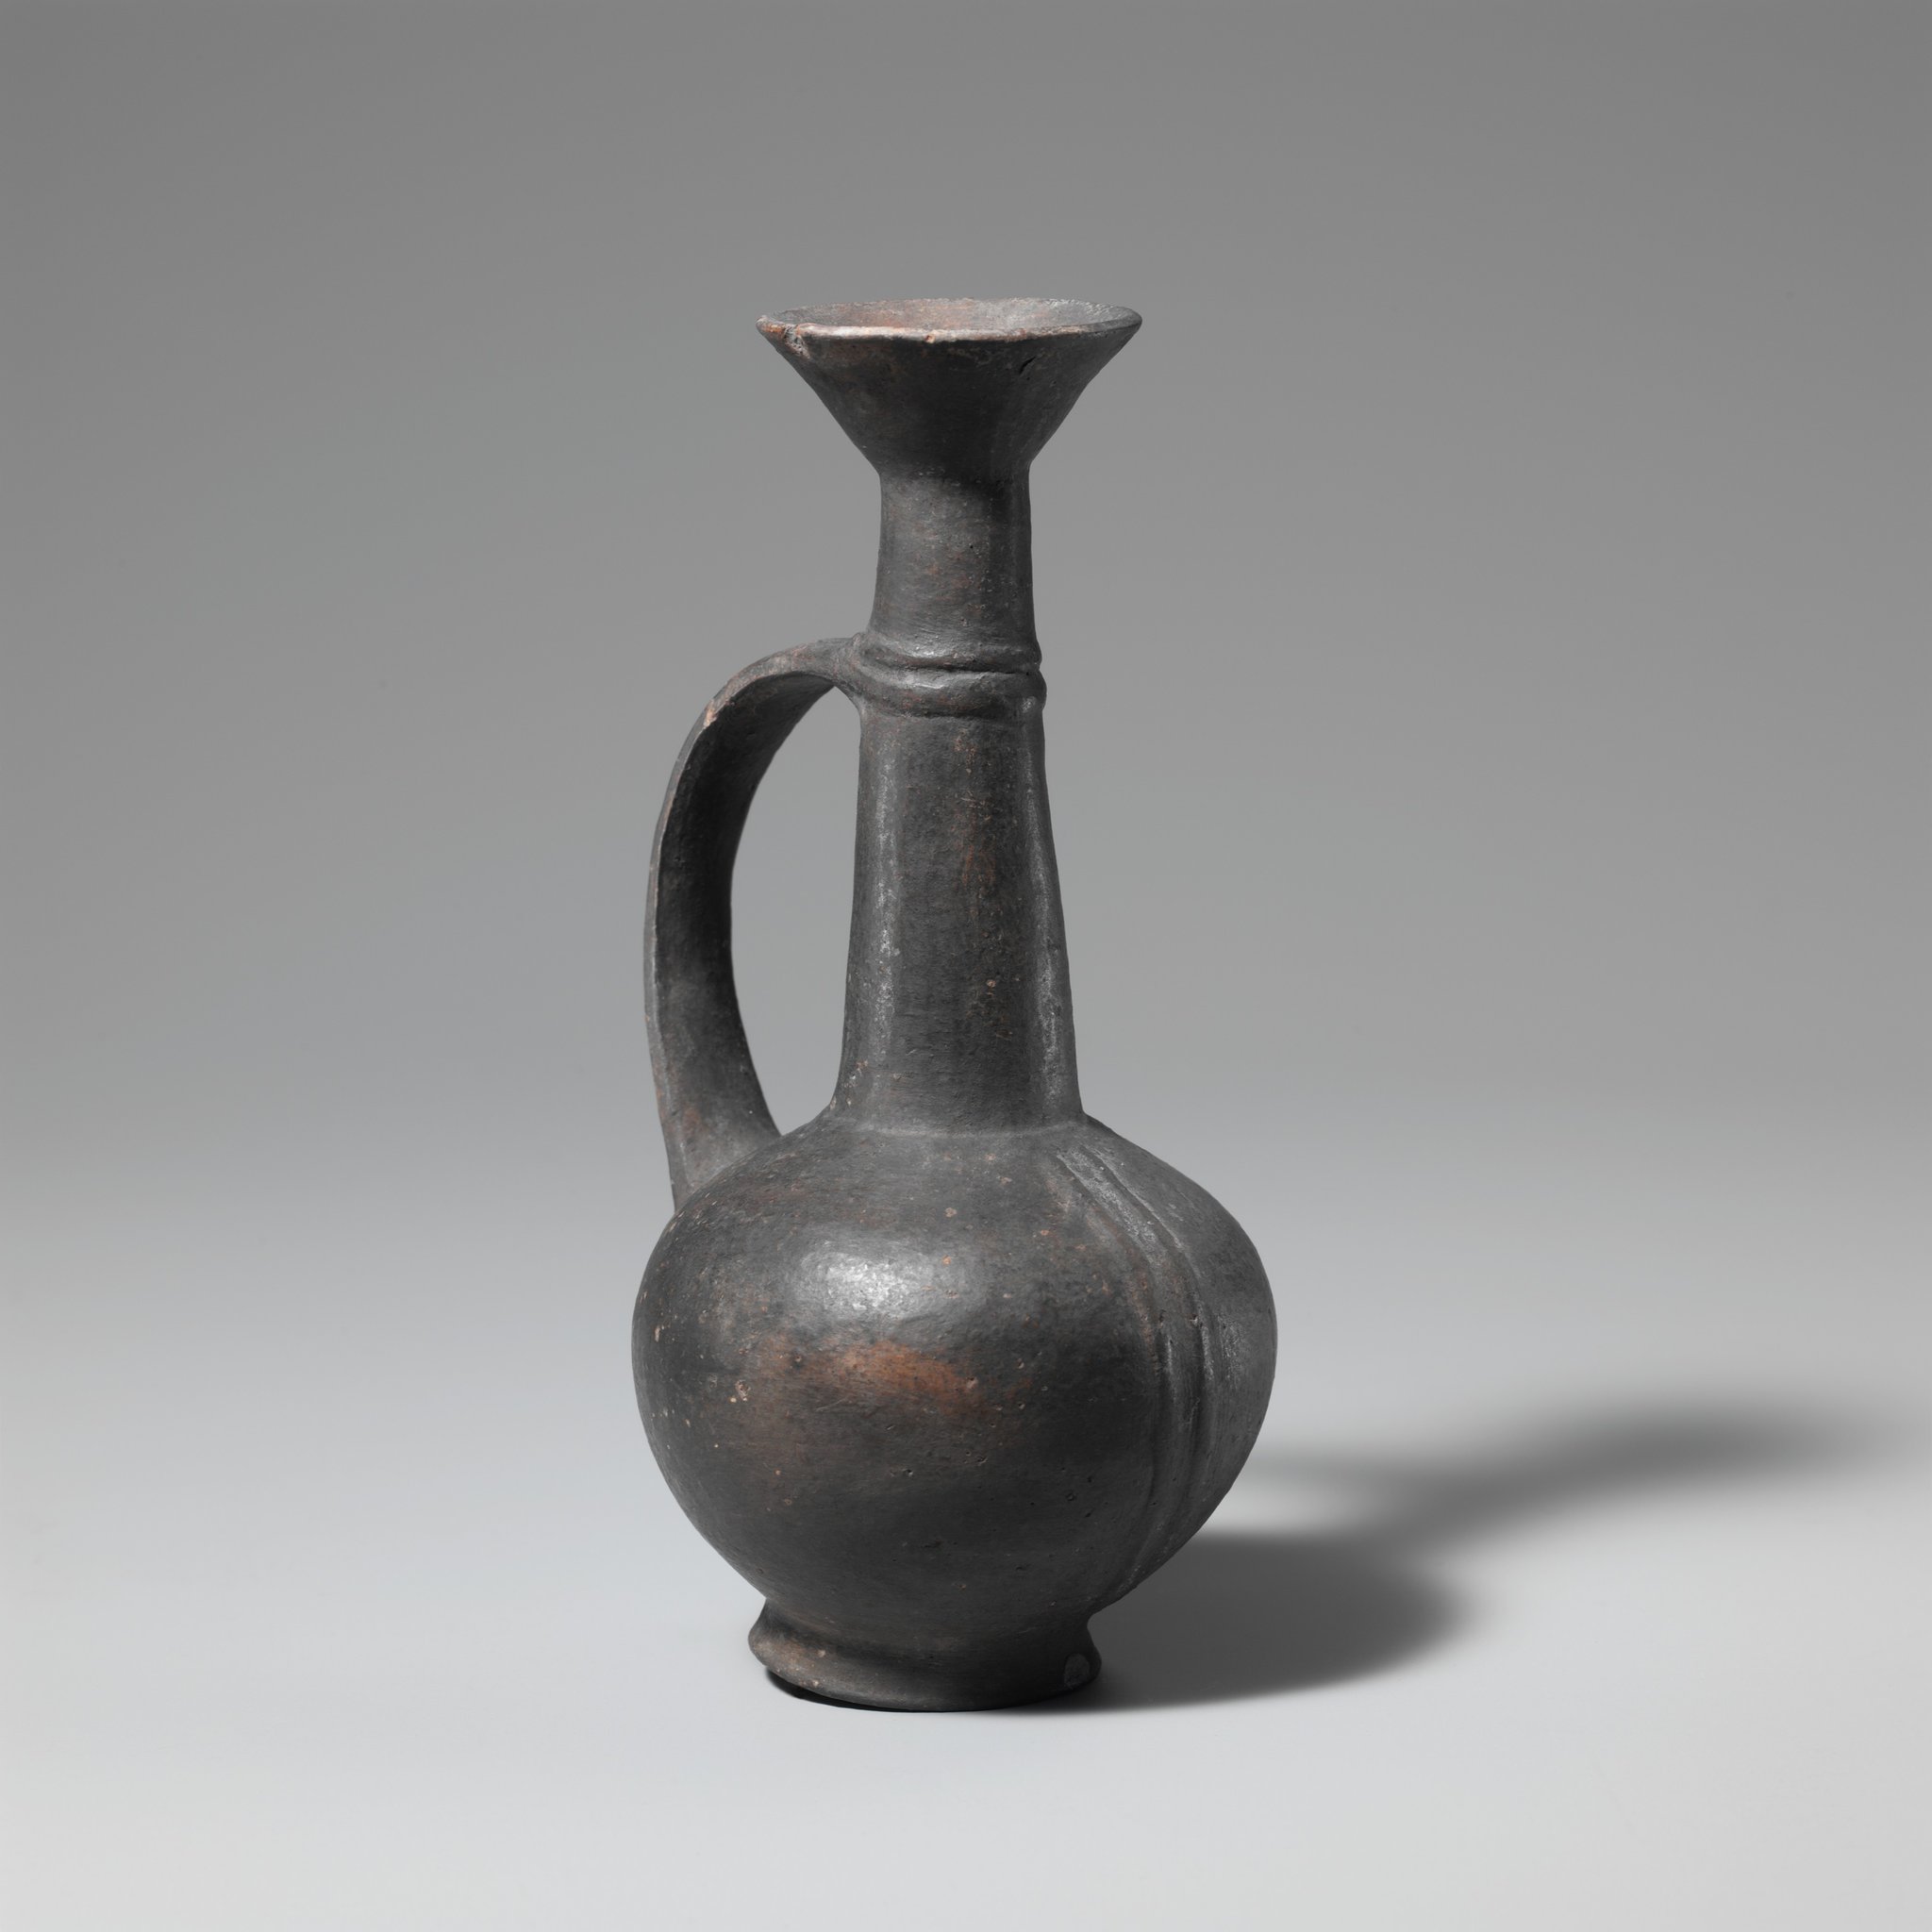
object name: juglet, cypriot, ring based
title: Cypriote ring based juglet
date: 1500-1400 BCE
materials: pottery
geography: egypt